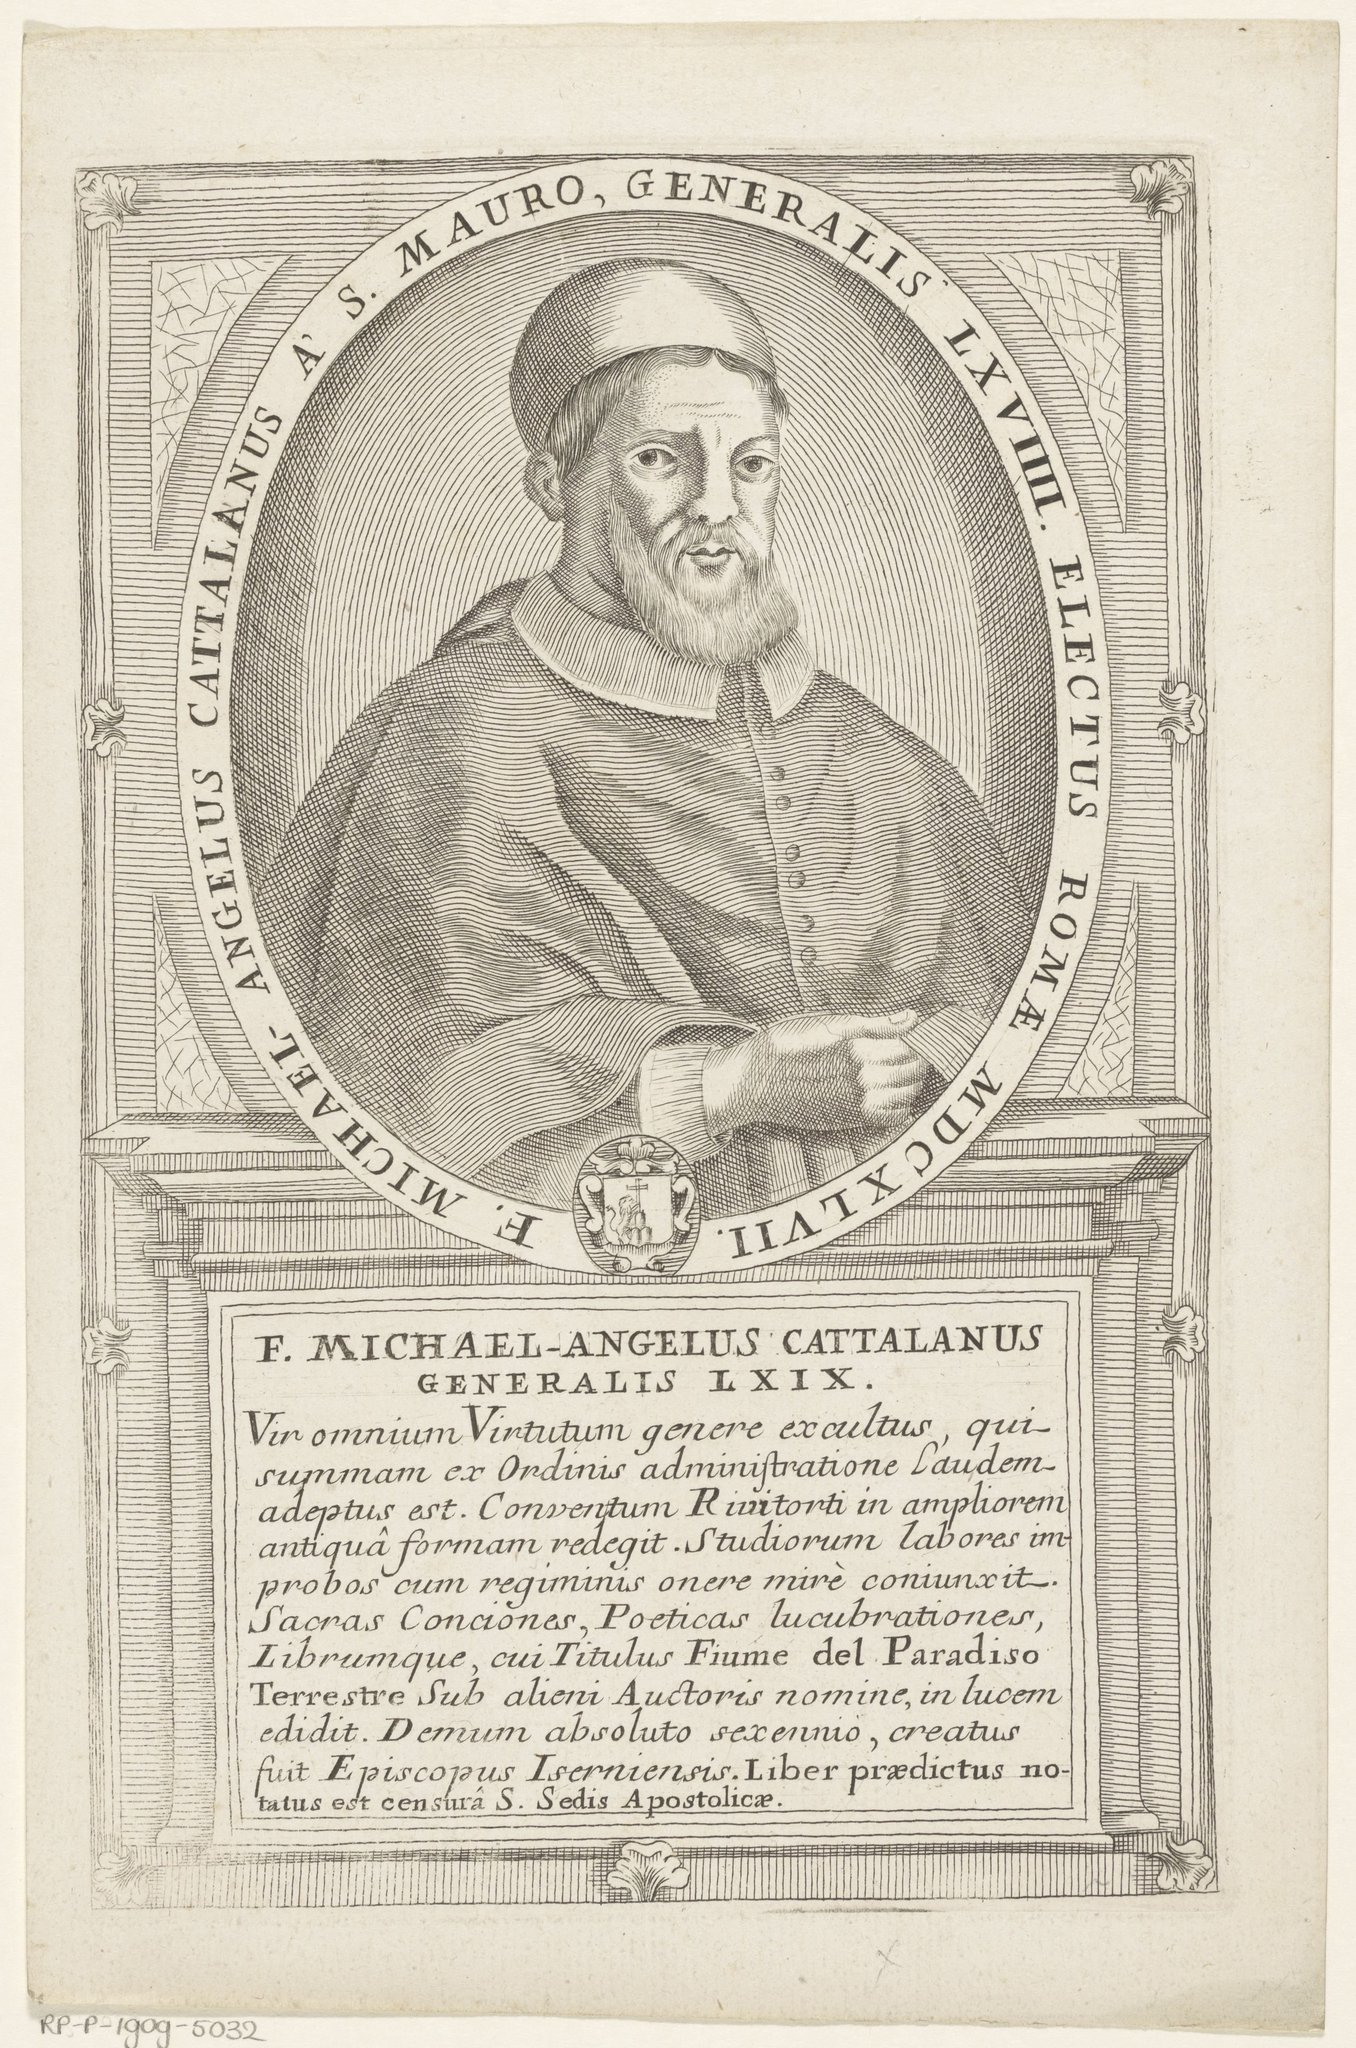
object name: print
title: Portretten van Ministers Generaal van de franciscaner orde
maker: antonio luciani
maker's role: print maker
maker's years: 1700-1738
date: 1710-1738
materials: paper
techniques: engraving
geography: italy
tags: historical persons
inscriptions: collector's mark: Lugt 2228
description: Deze prent maakt deel uit van een groep van 60 portretten.